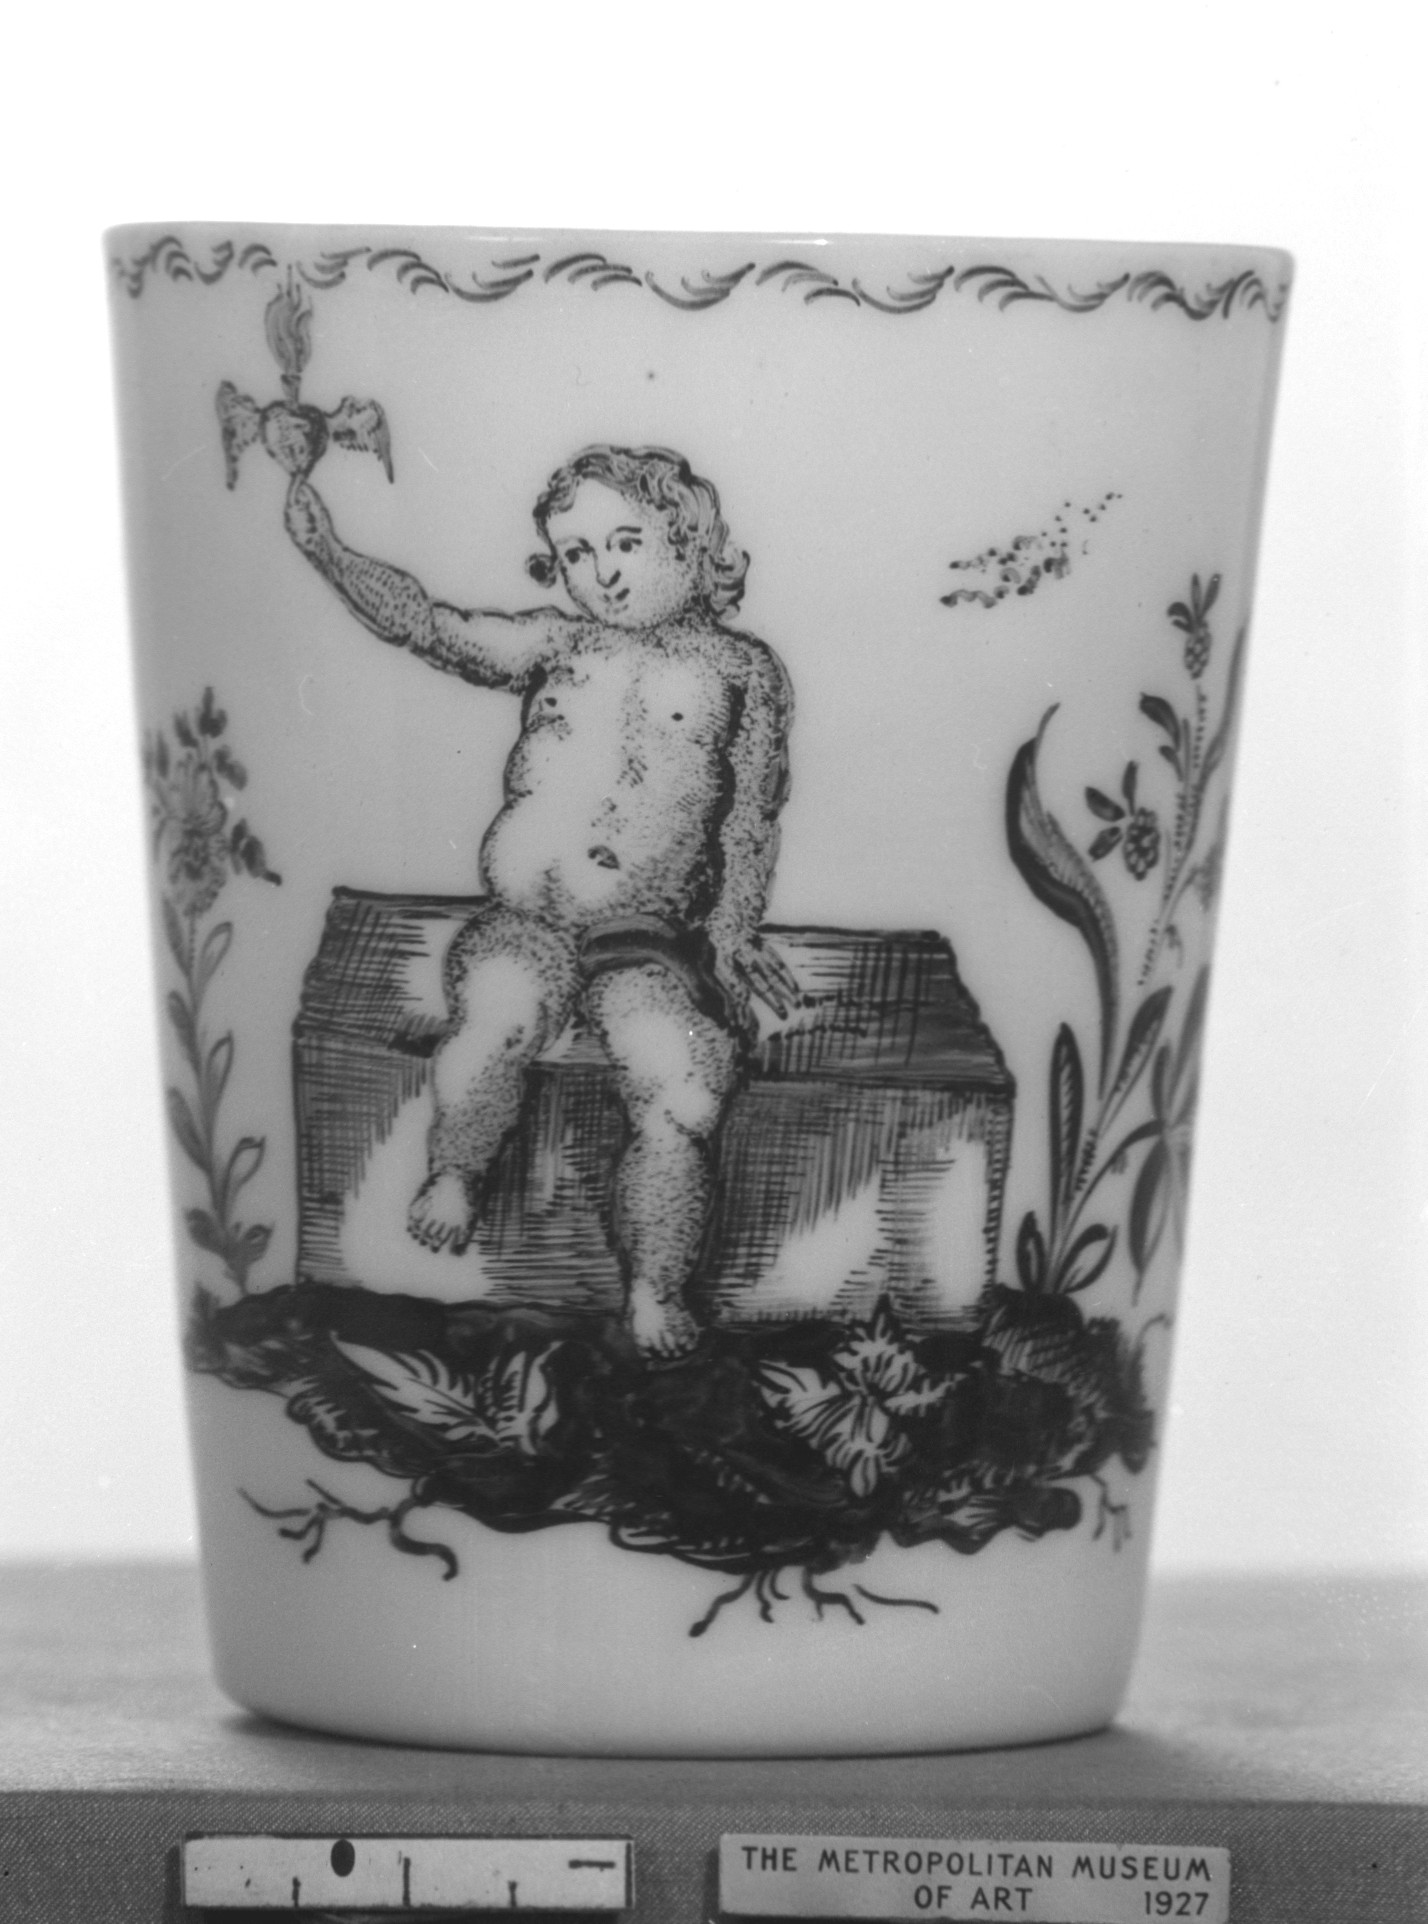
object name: beaker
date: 1780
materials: glass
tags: children